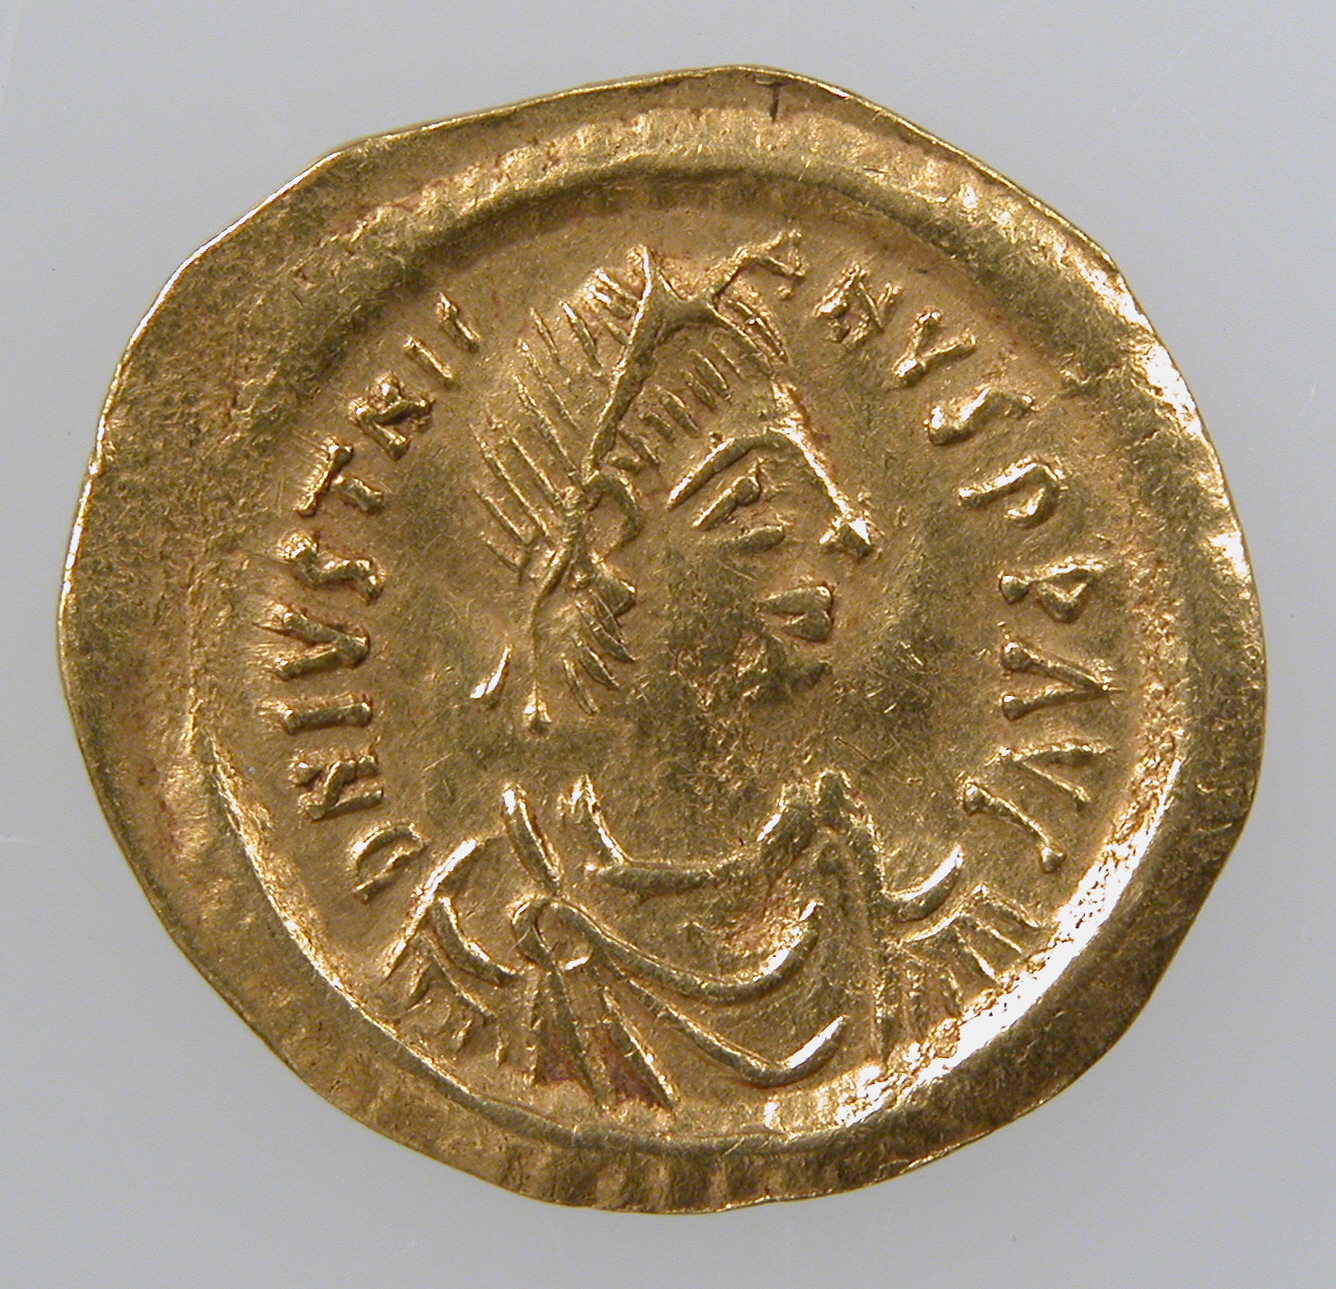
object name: tremissis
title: Gold Tremissis of Emperor Justinian I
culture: byzantine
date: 527-602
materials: gold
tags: profiles